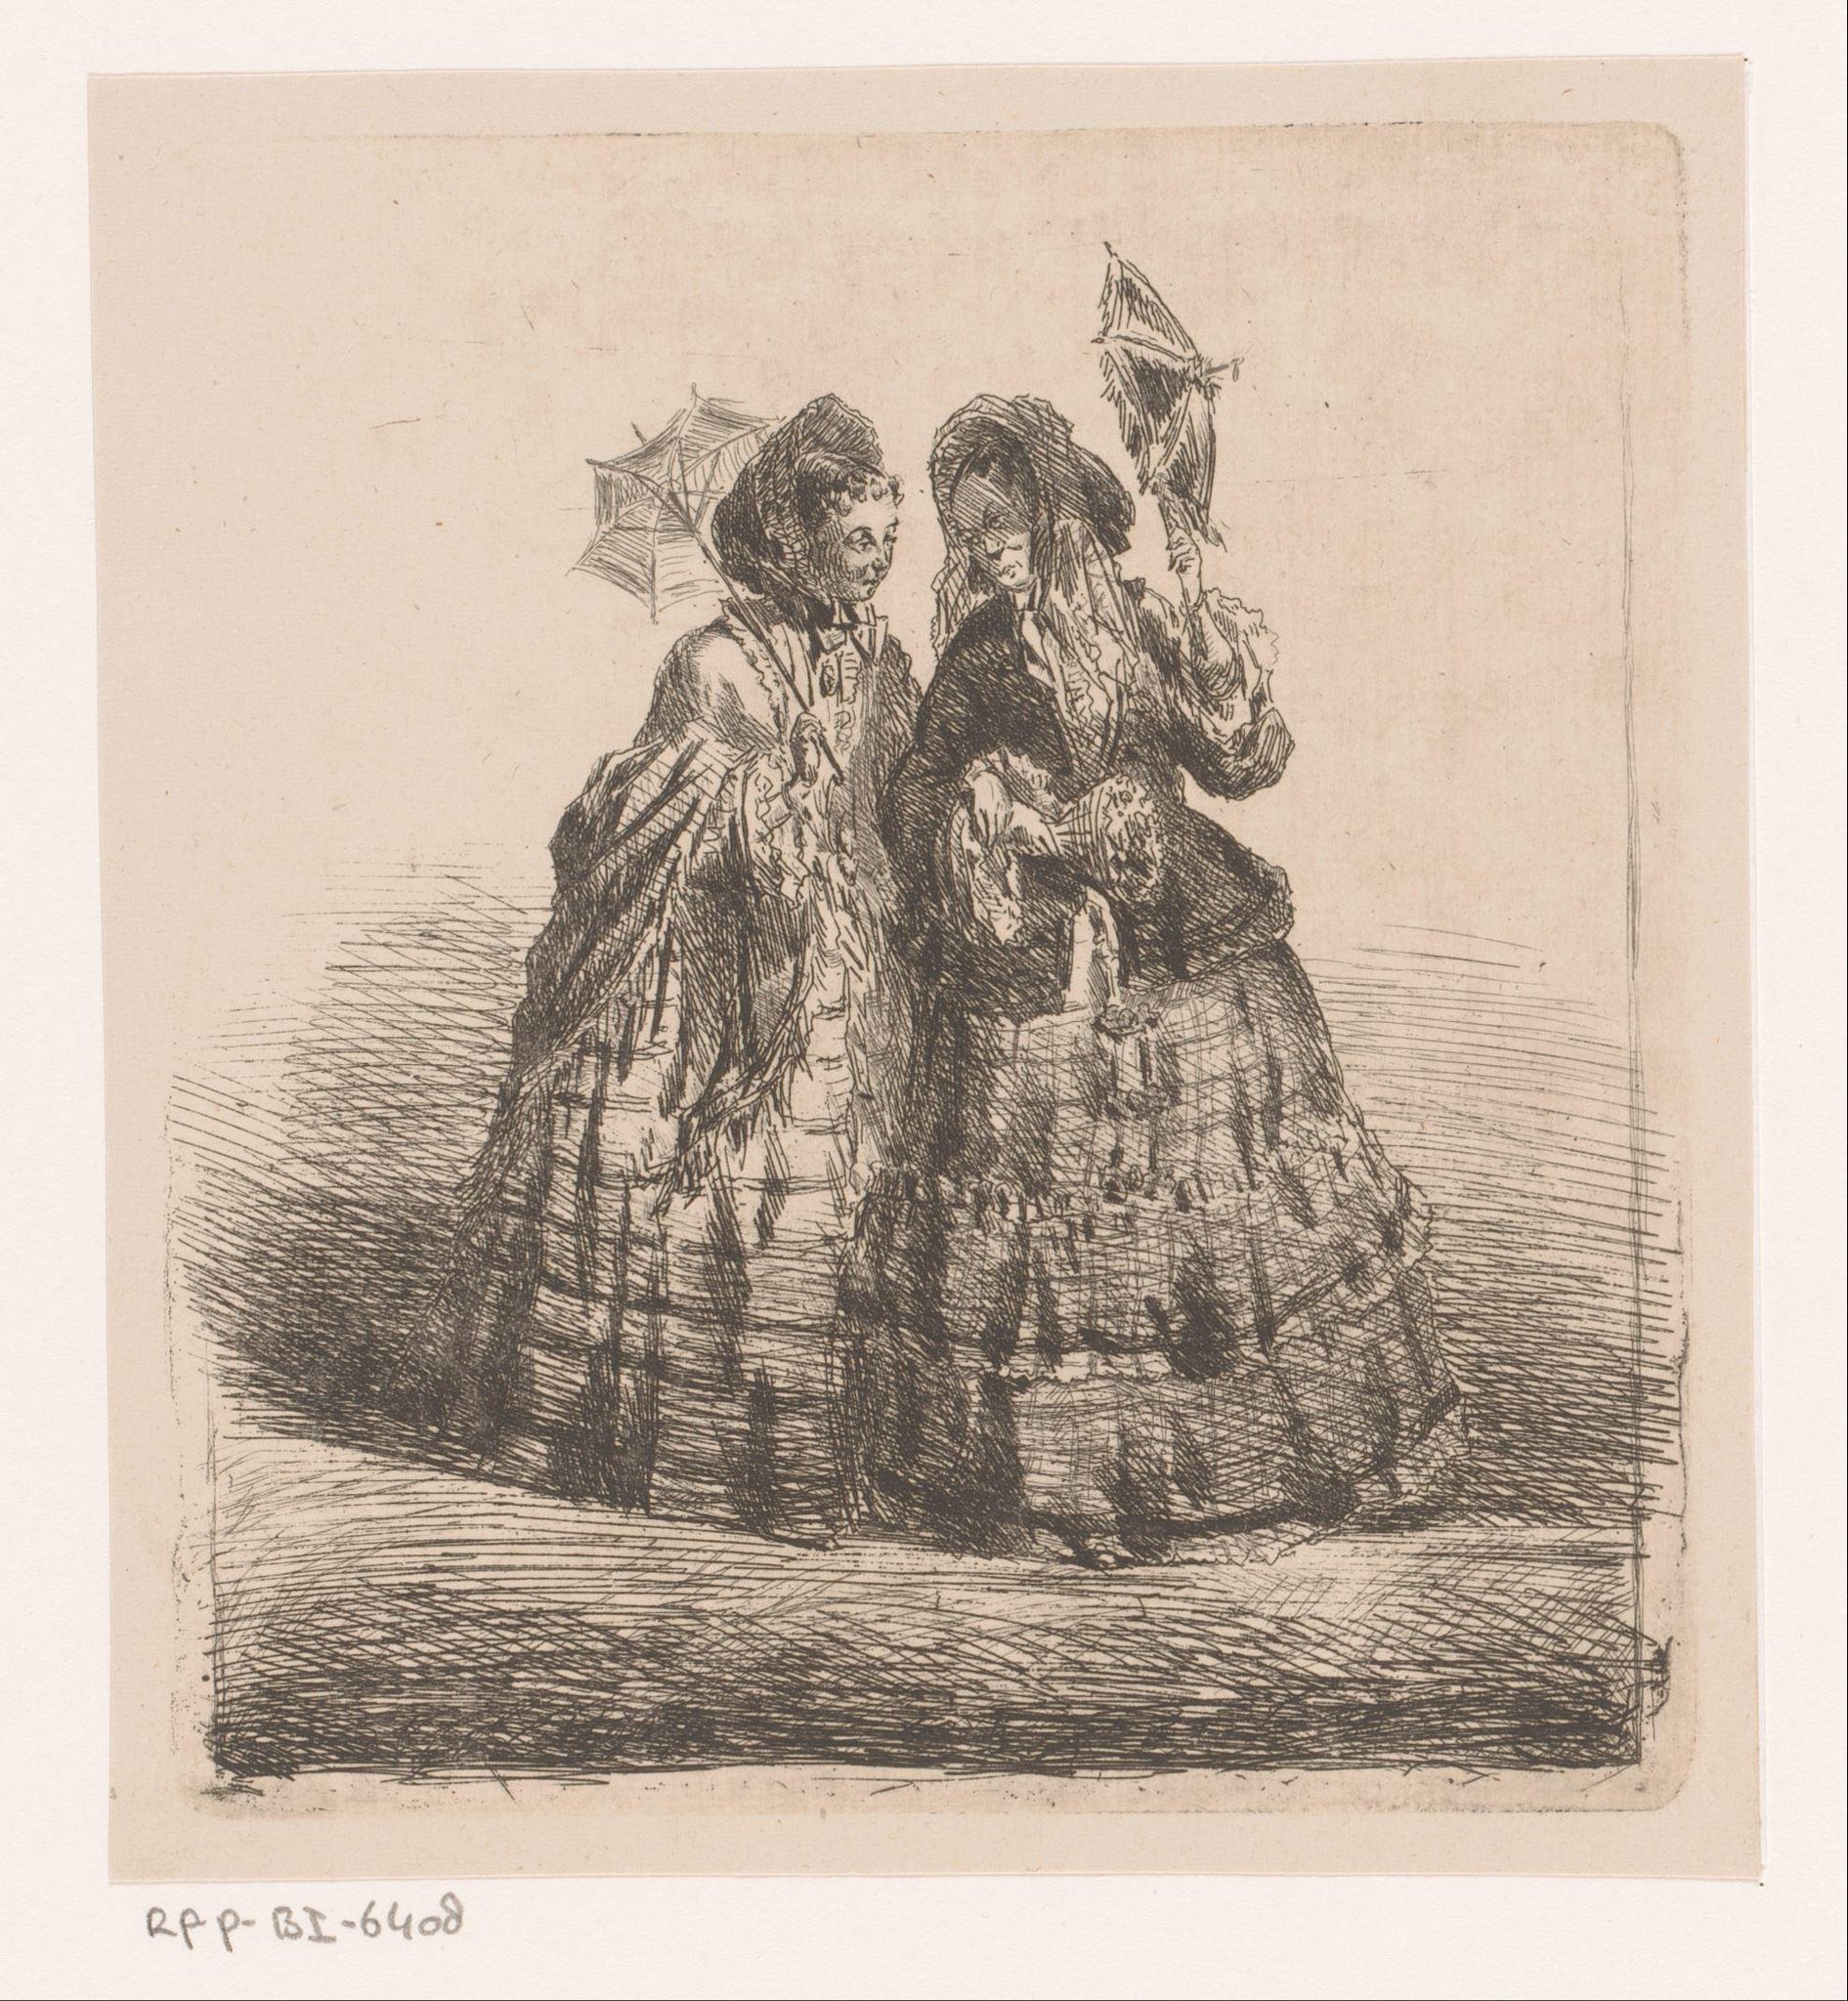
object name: print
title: Twee vrouwen met parasol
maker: florent nicolas crabeels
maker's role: print maker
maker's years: 1829-1896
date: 1853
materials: paper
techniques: etching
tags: adult woman (+ two persons), parasol, sunshade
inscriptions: collector's mark: Lugt 2228